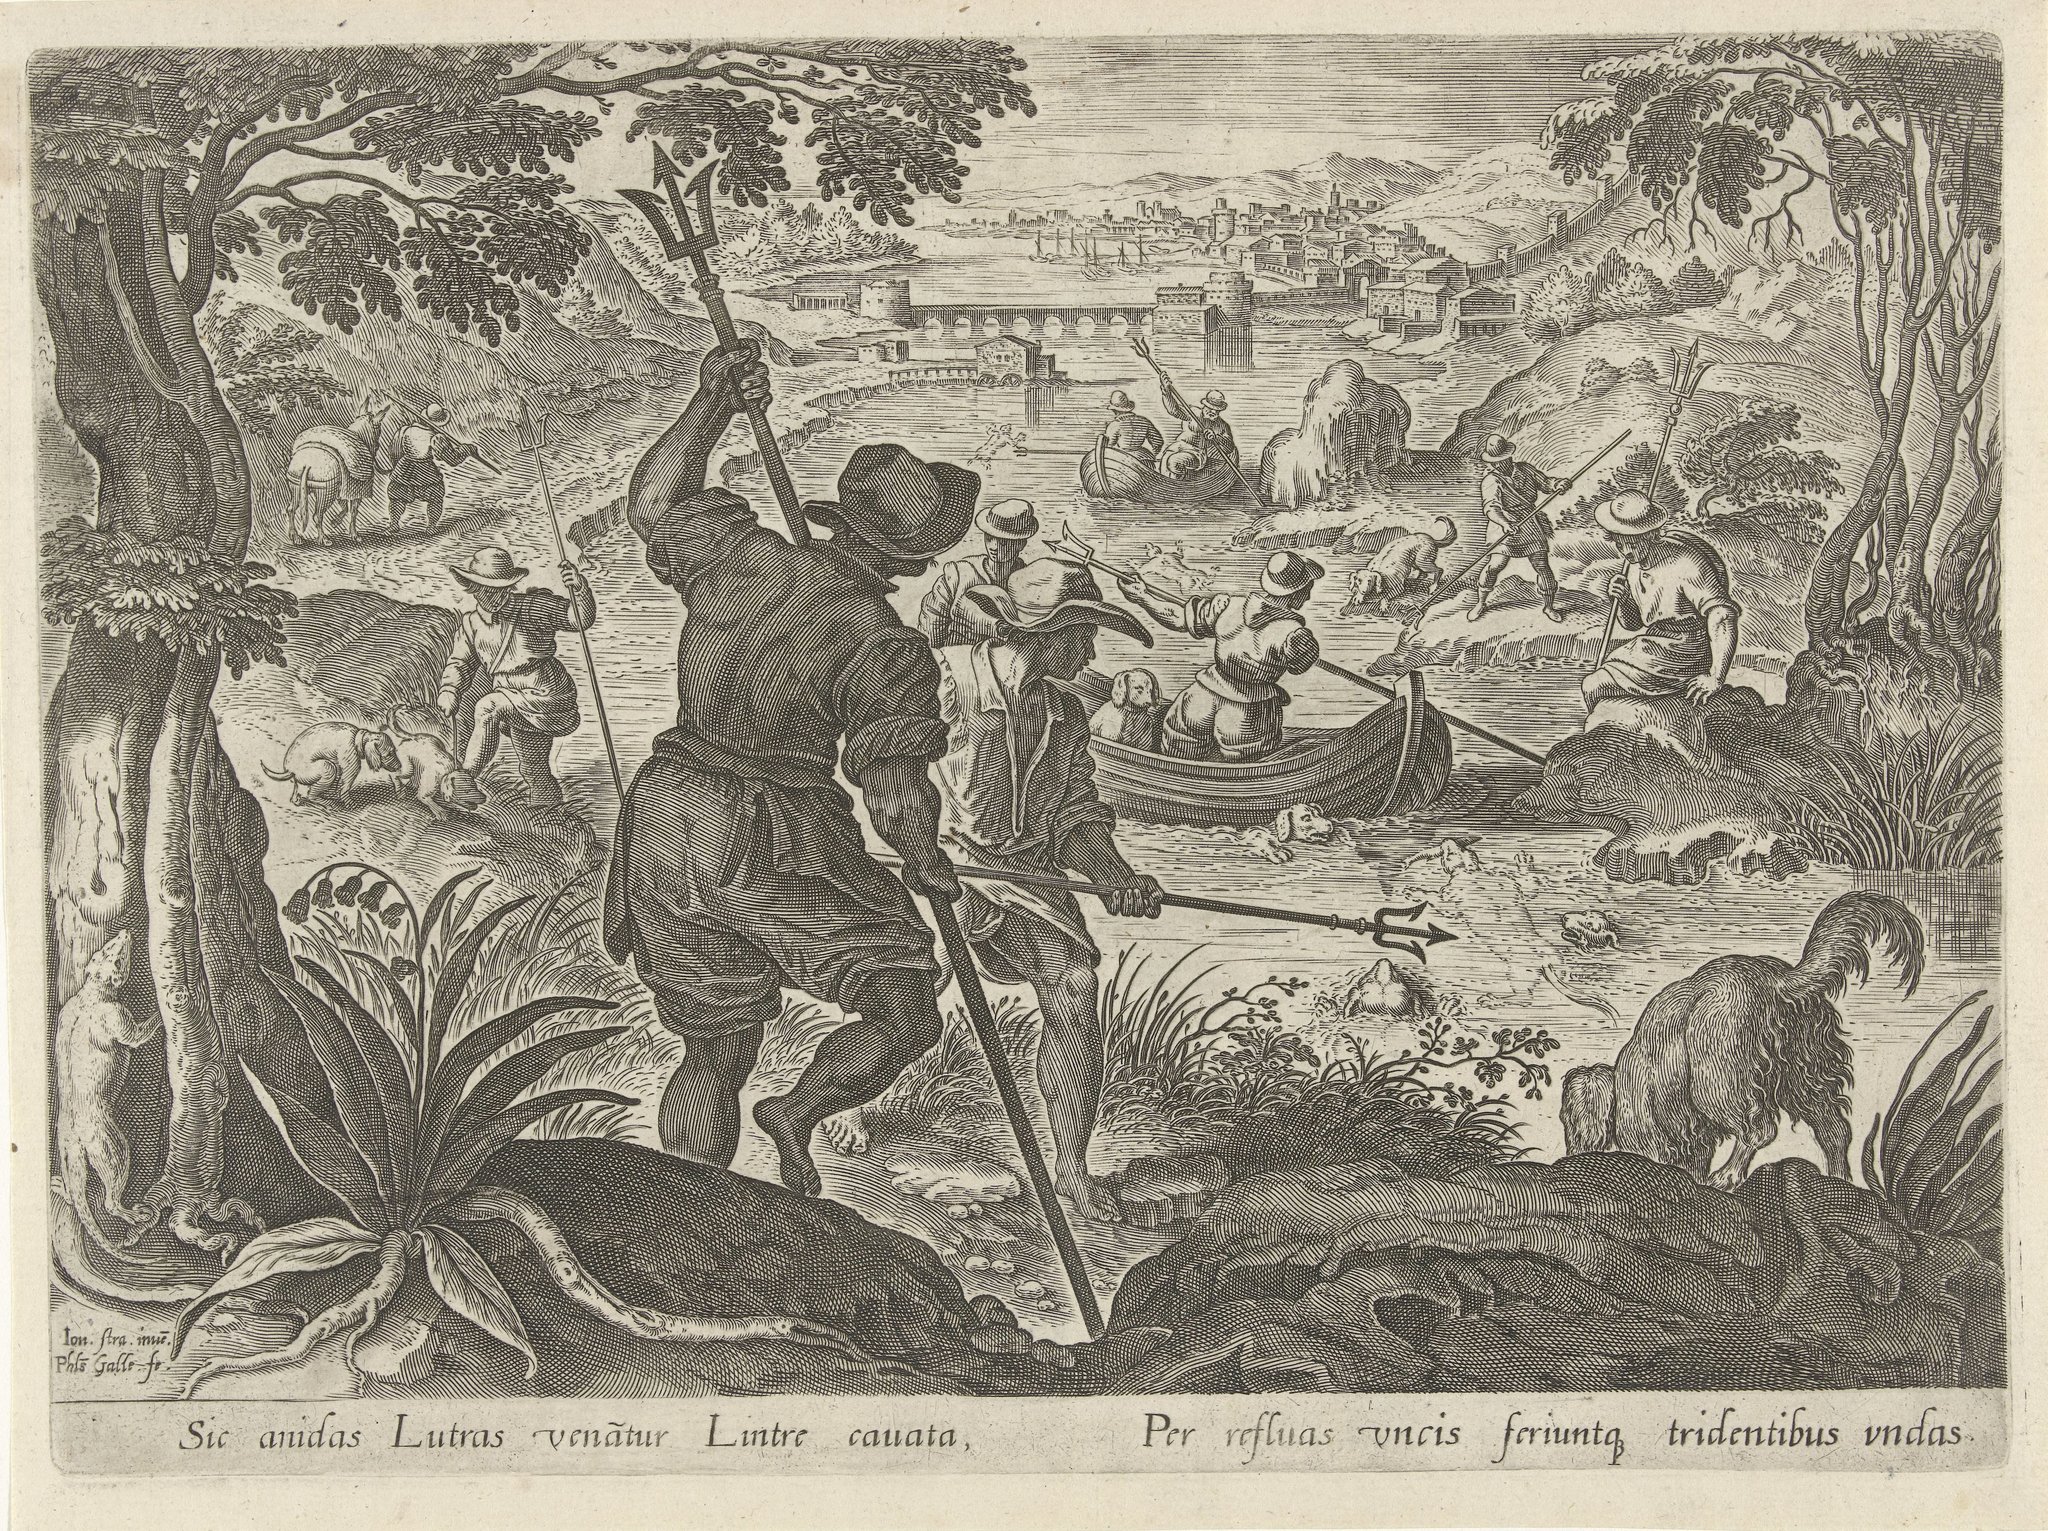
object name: print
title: Jacht op otters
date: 1578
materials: paper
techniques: engraving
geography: antwerp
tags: beasts of prey, predatory animals: otter, hunt ~ predatory animals (fox, lion) (+ hunting with dogs), hunt ~ predatory animals (fox, lion) (+ trident)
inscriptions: collector's mark: Lugt 2228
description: Jagers maken jacht op otters met behulp van honden en drietanden. De prent heeft een Latijns onderschrift en maakt deel uit van een 43-delige serie over de jacht.